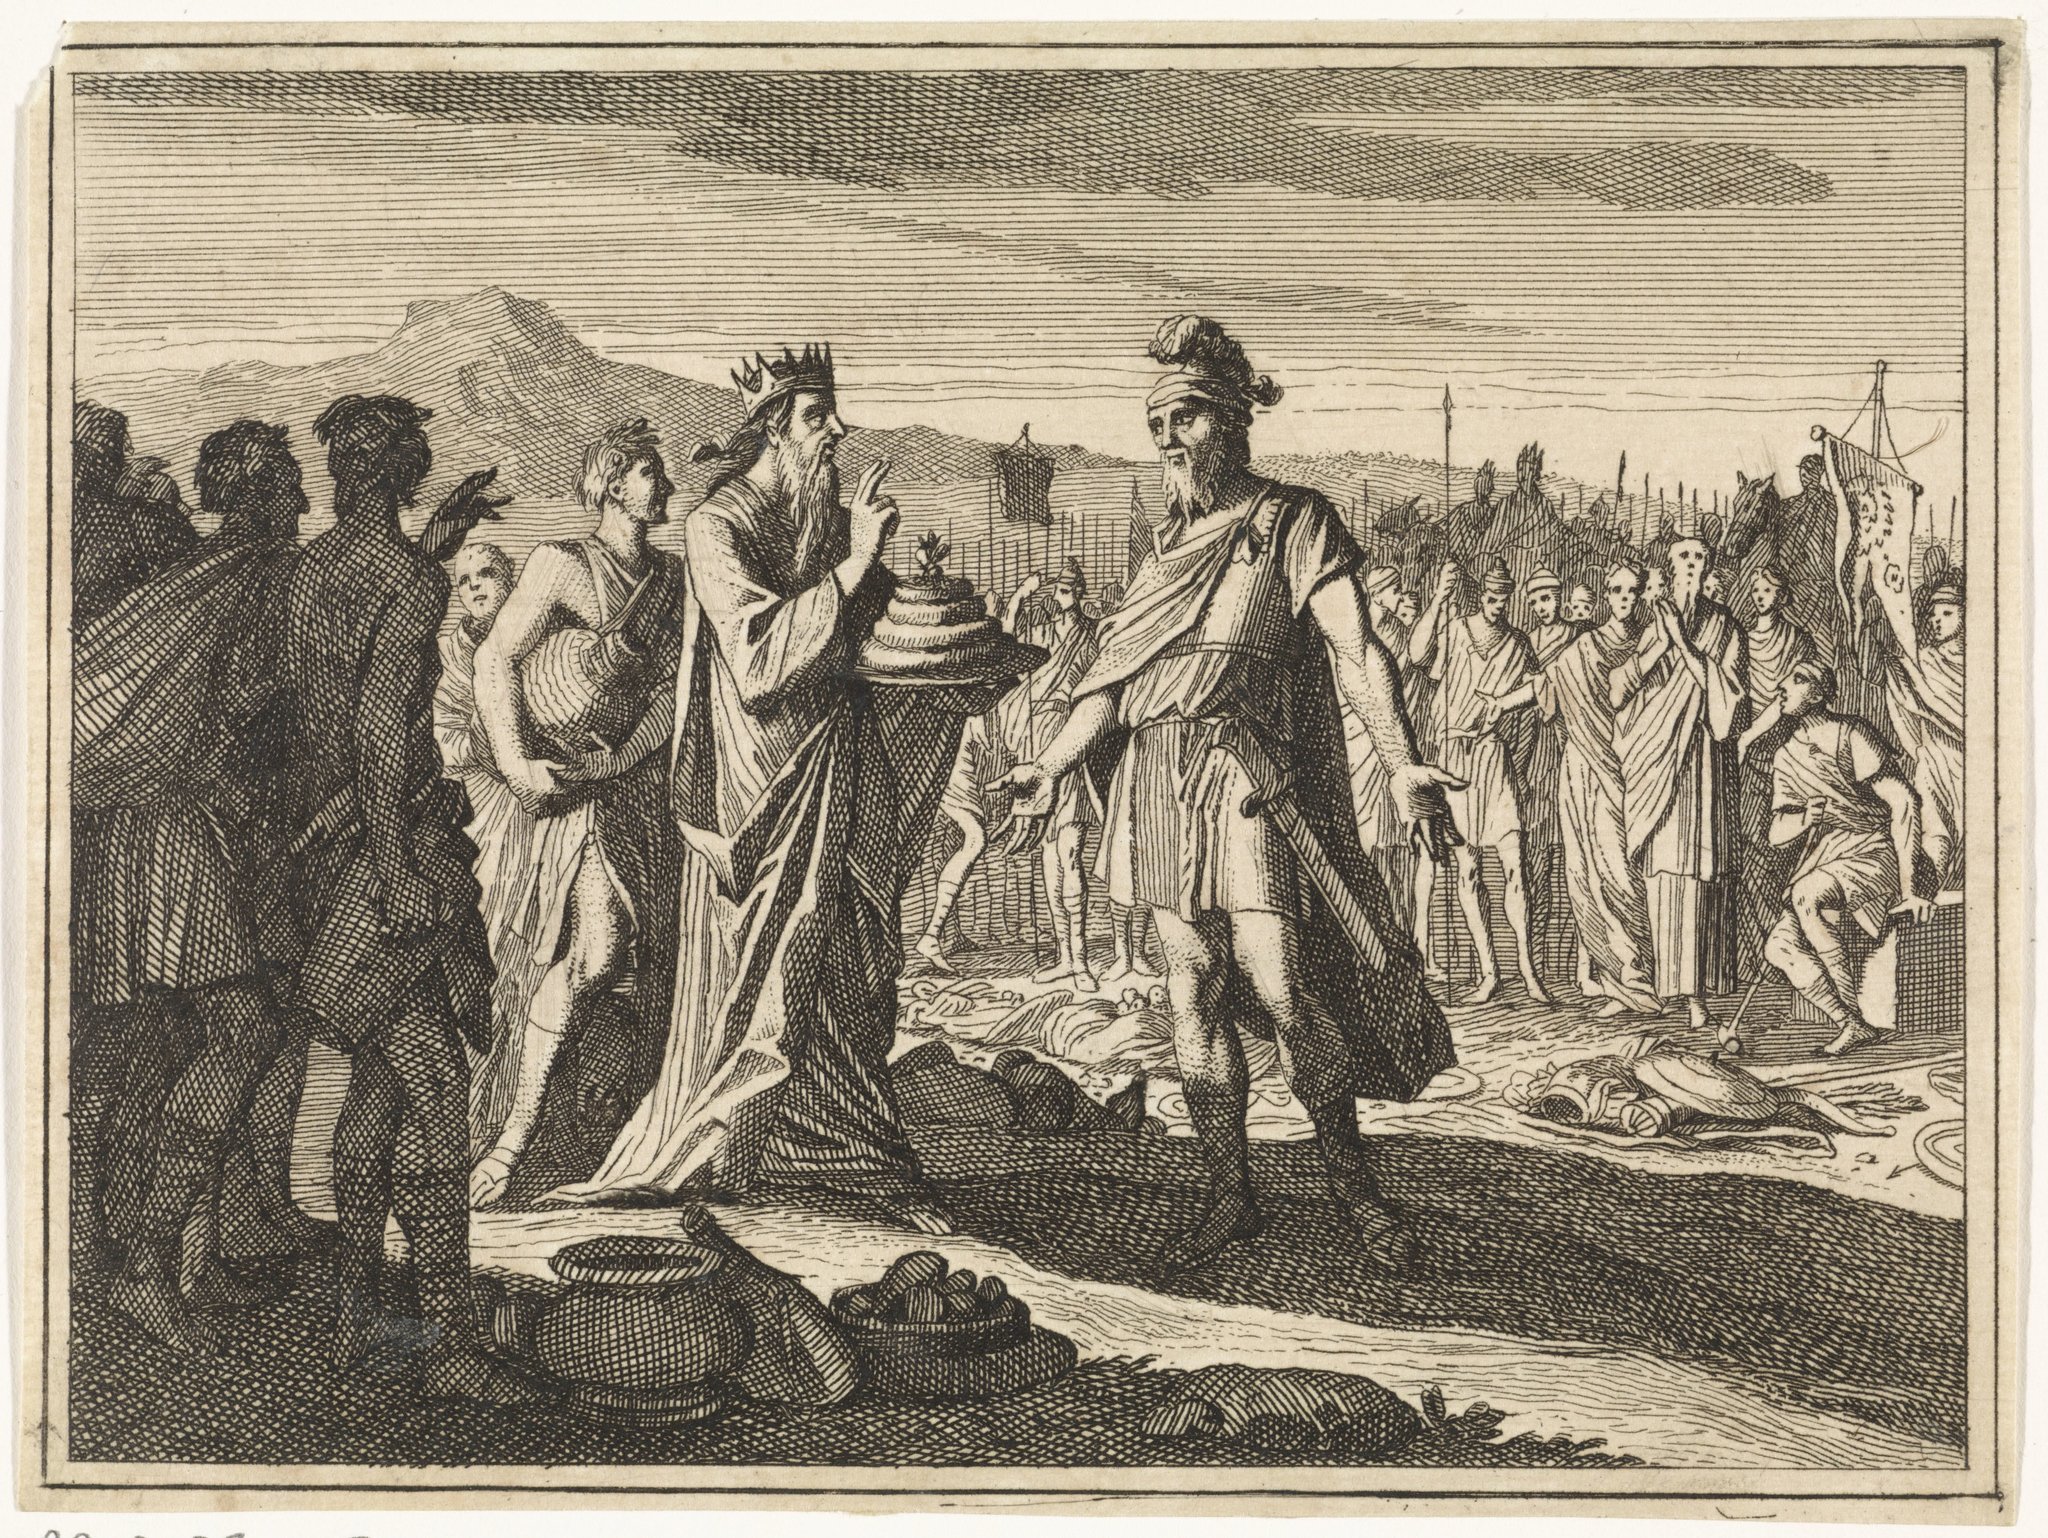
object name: print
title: Abraham ontmoet koning Melchisedek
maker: caspar luyken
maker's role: draughtsman, print maker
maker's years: 1672-1708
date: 1712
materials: paper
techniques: etching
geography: amsterdam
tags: the meeting of abraham and melchizedek, the high priest and king of salem, who brings bread and wine (genesis 14:18-20)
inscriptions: collector's mark: Lugt 2228, number: ‘19’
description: Illustratie uit: Luyken, Jan. De schriftuurlyke geschiedenissen en gelykenissen van het Oude en Nieuwe Verbond, 2 delen. Amsterdam: Wed. Pieter Arentsz II en Cornelis van der Sys, 1712, dl. I.